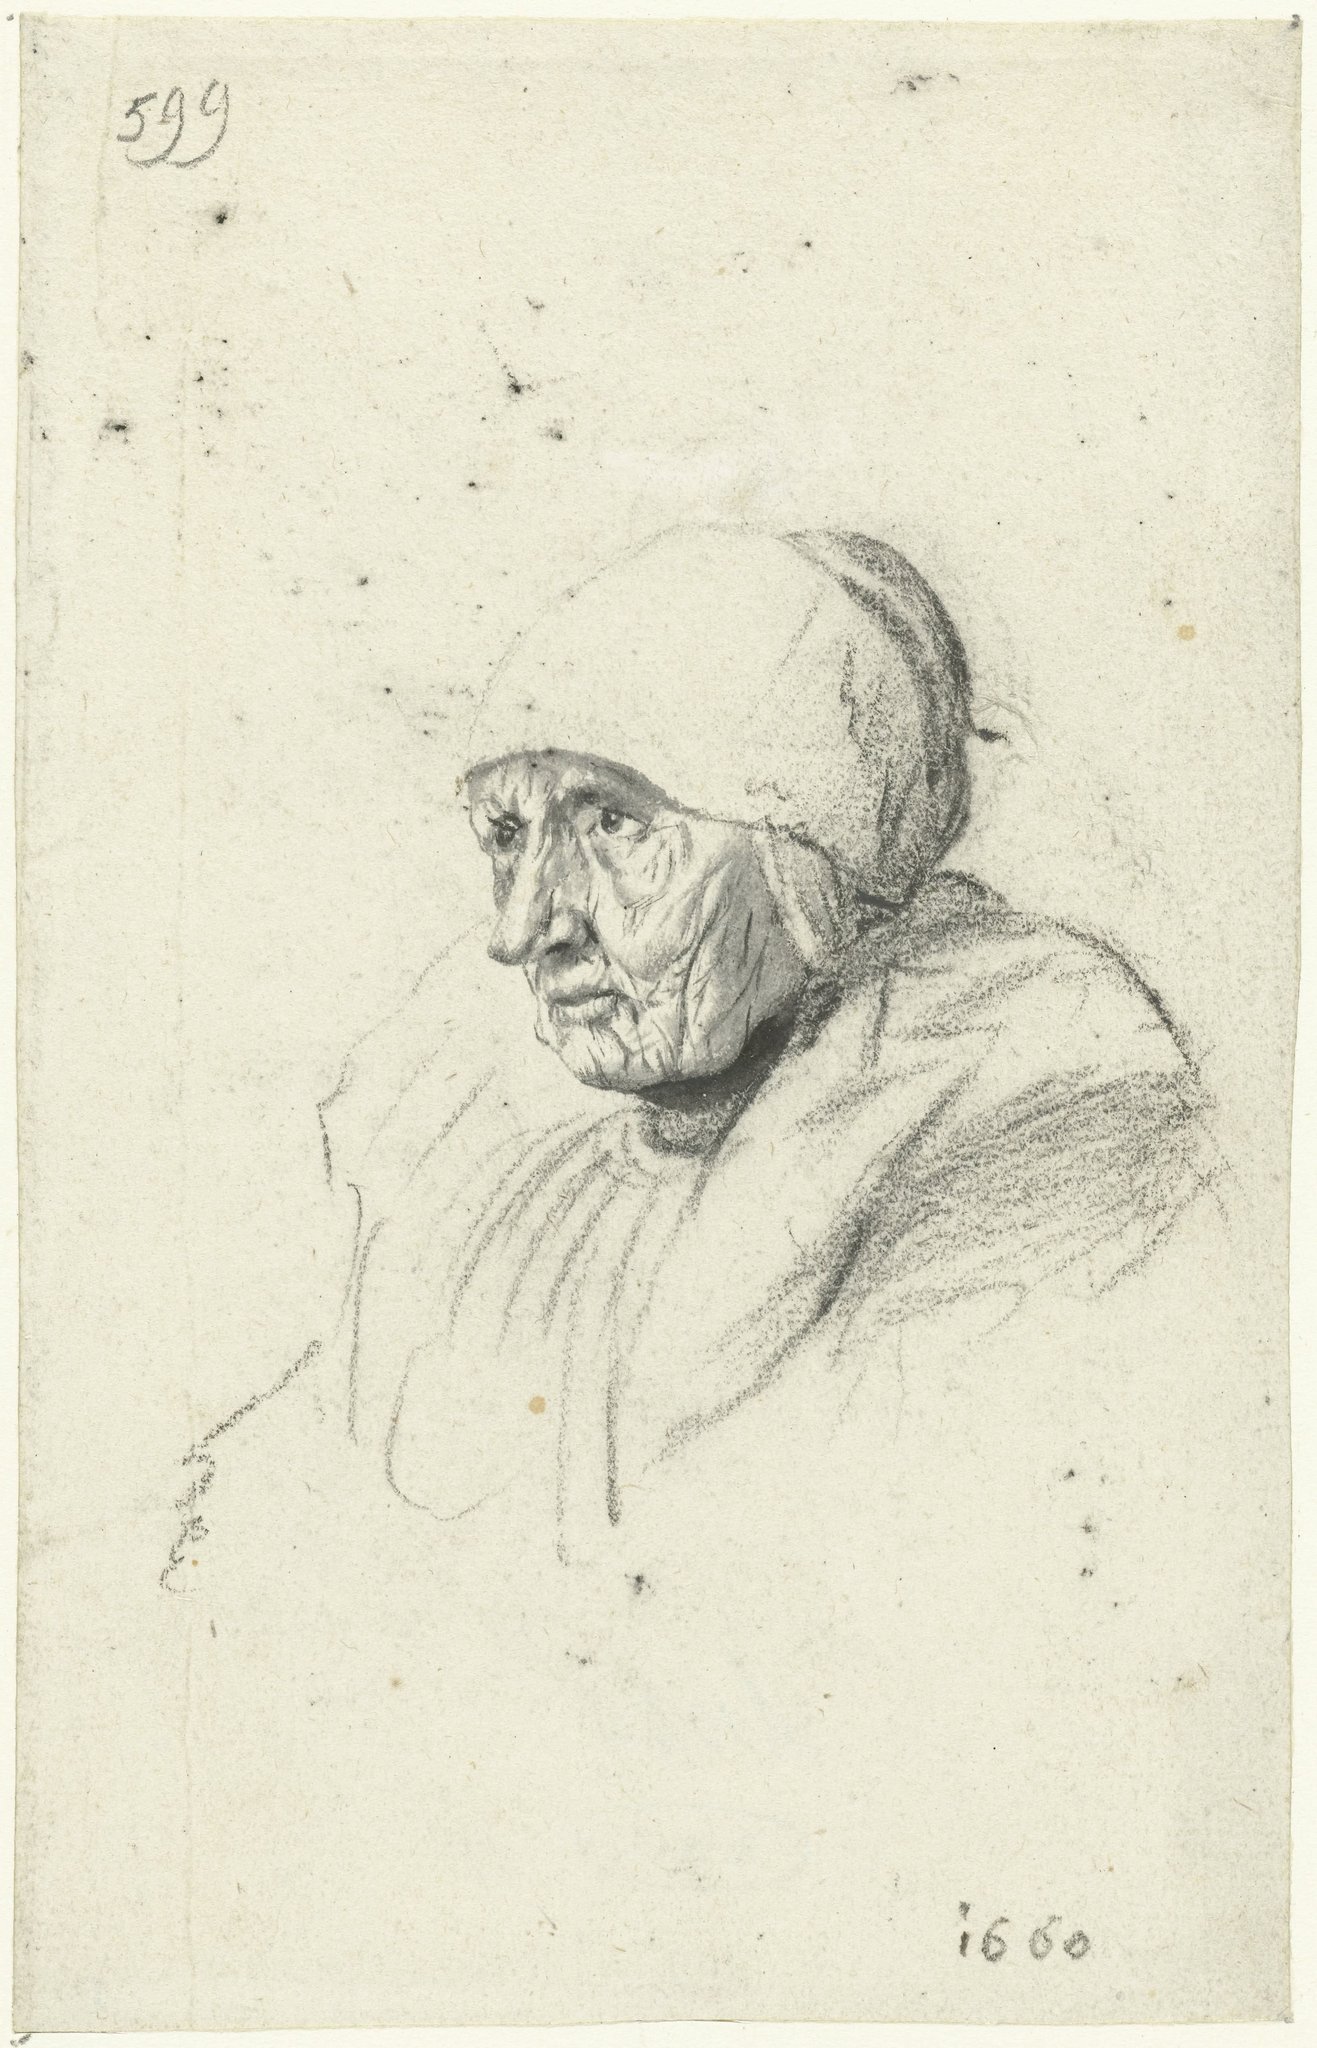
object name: drawing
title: Hoofd en schouders van een oude vrouw, naar links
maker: moses ter borch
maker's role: draughtsman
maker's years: 1645-1667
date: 1660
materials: chalk, ink, paper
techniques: brush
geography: zwolle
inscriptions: date: ‘1660’, inscription: ‘11’